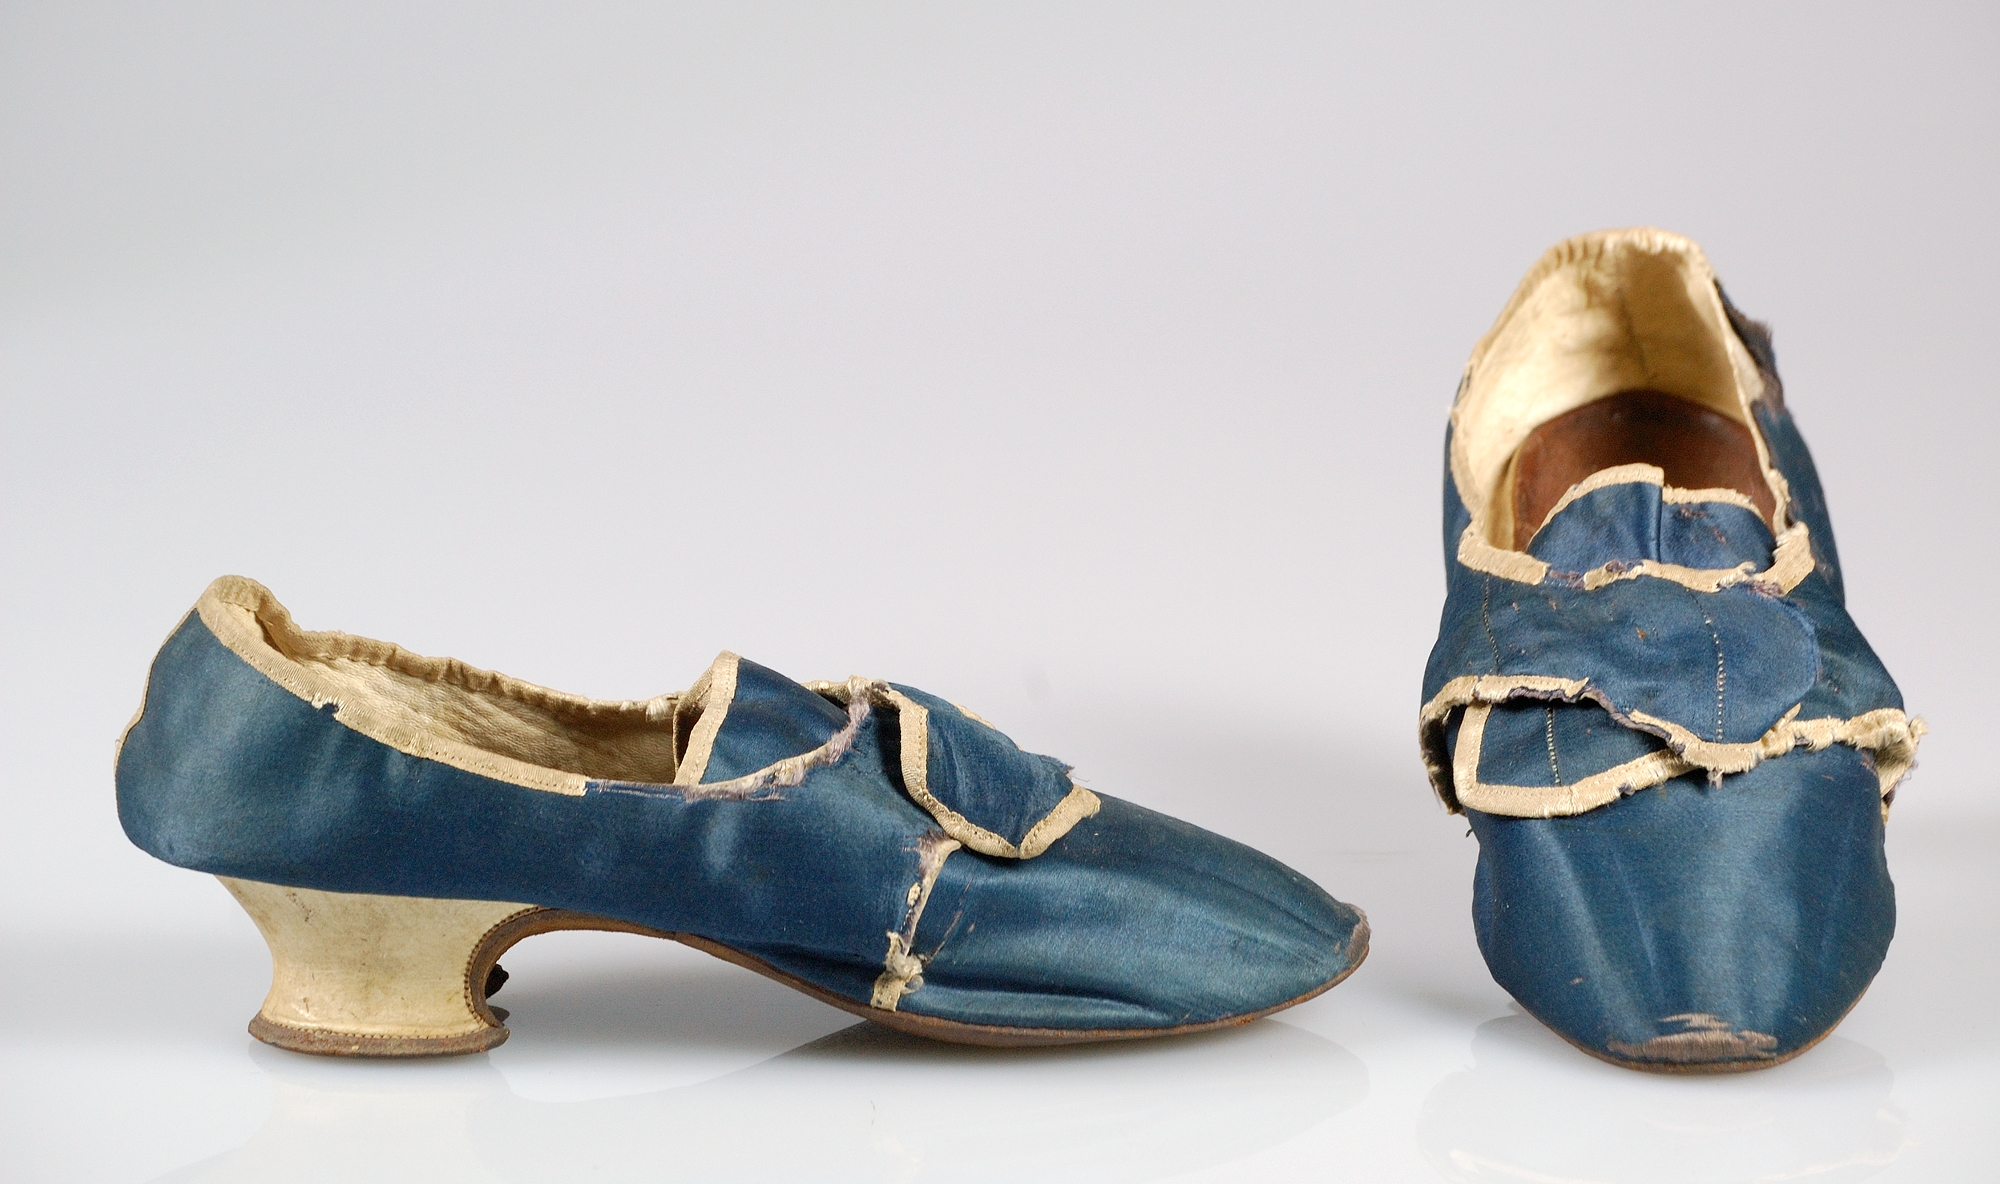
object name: shoe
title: Shoes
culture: european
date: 1755-1785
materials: leather, silk